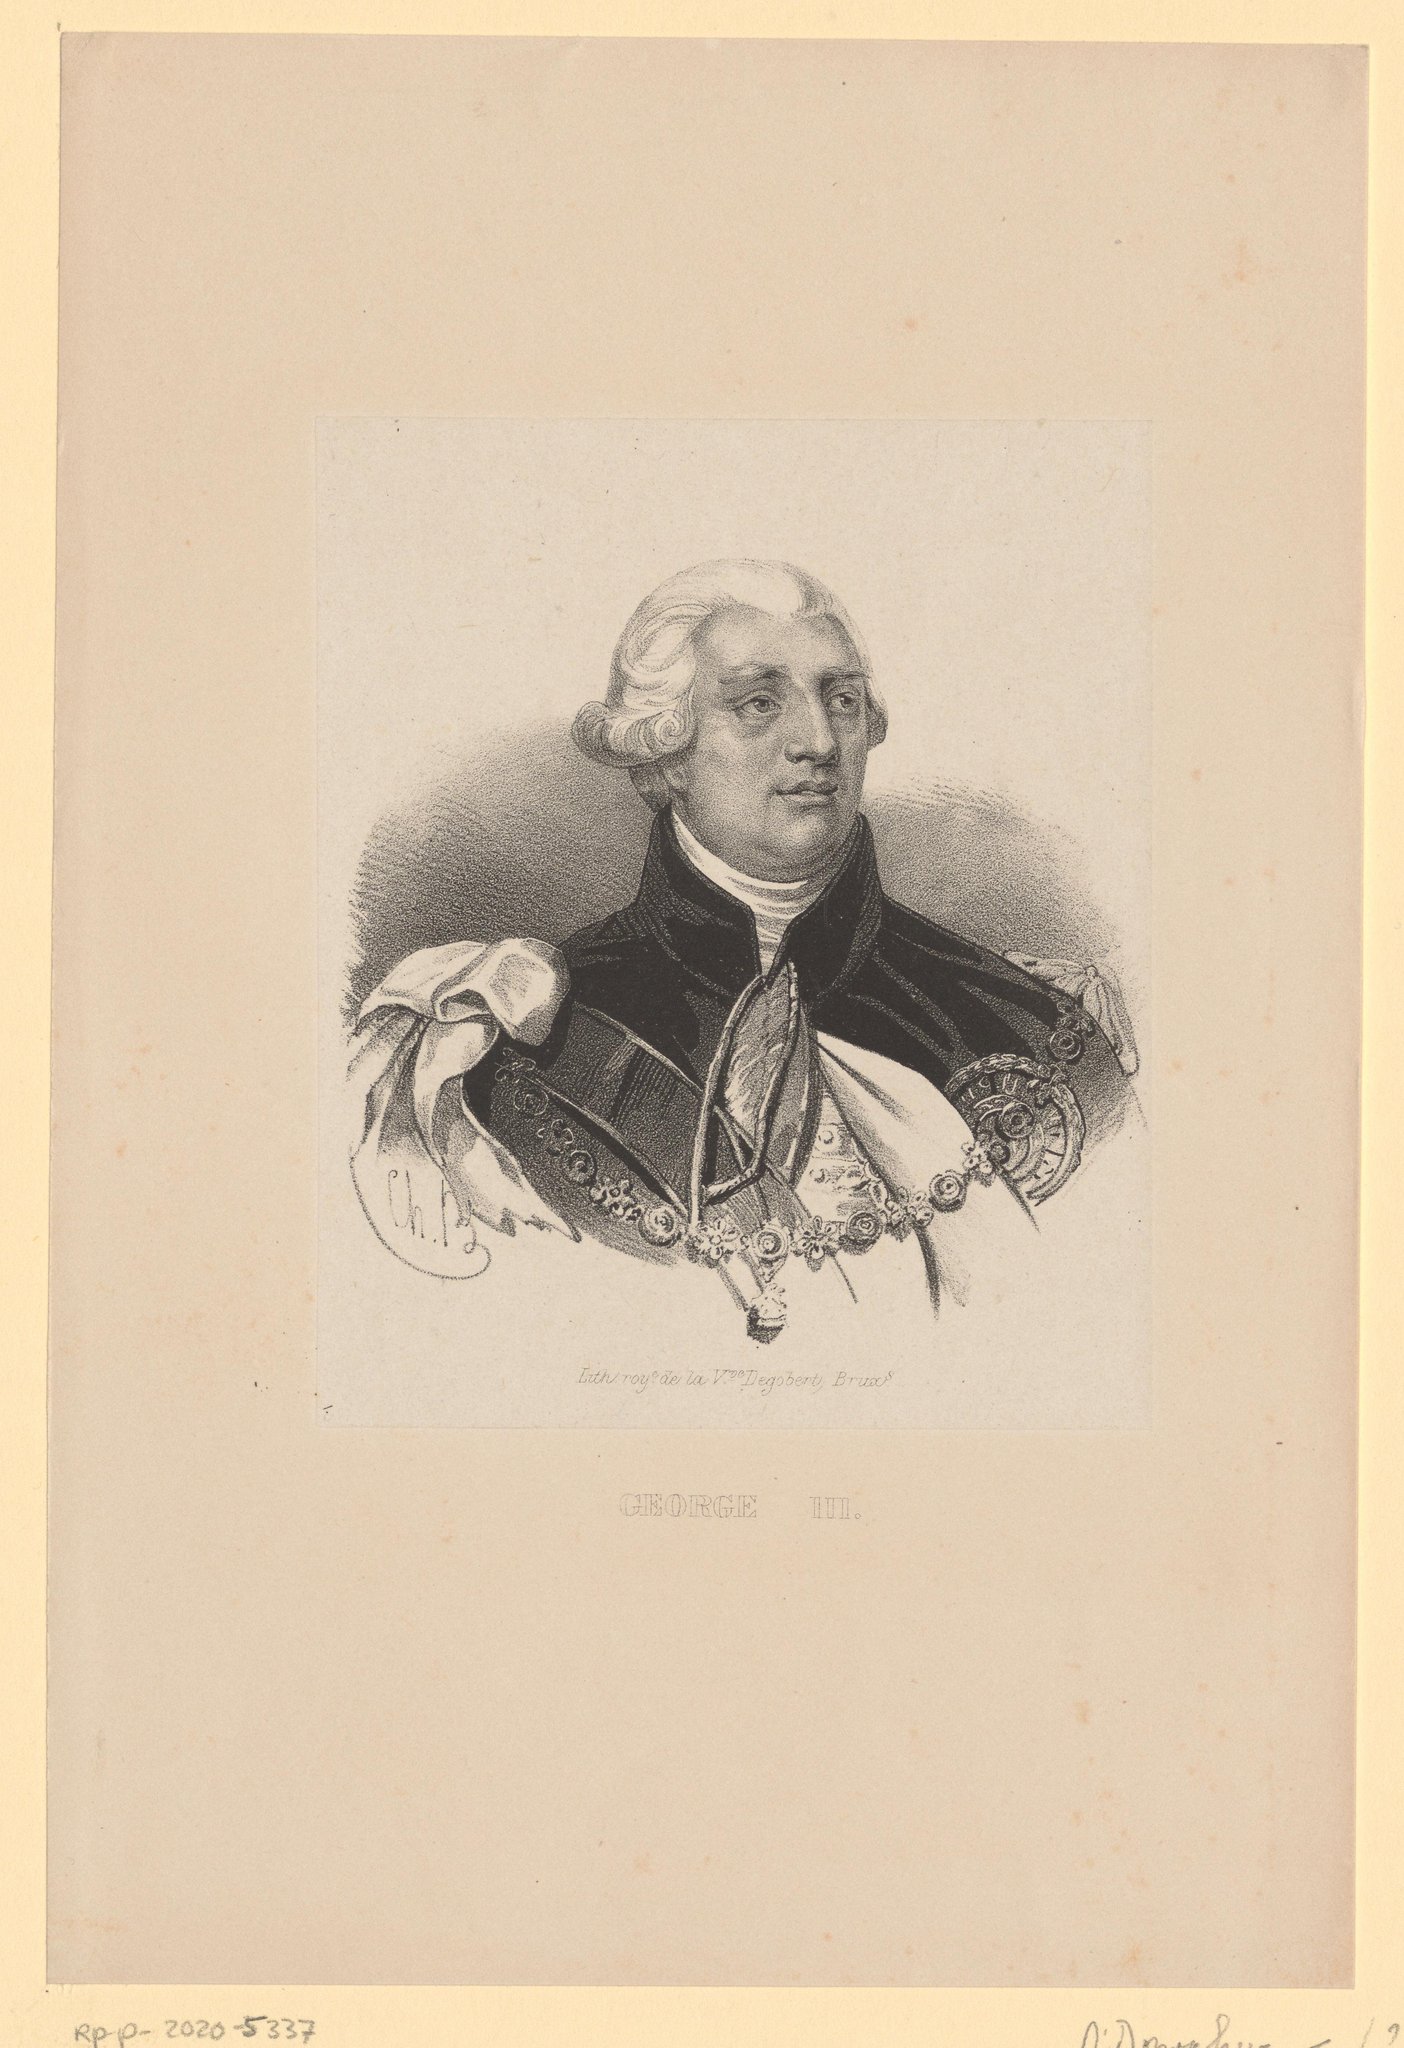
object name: print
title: Portret van George III, koning van het Verenigd Koninkrijk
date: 1844-1849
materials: paper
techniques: lithograph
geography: brussels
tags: london, george iii (koning van het verenigd koninkrijk), historical persons, king